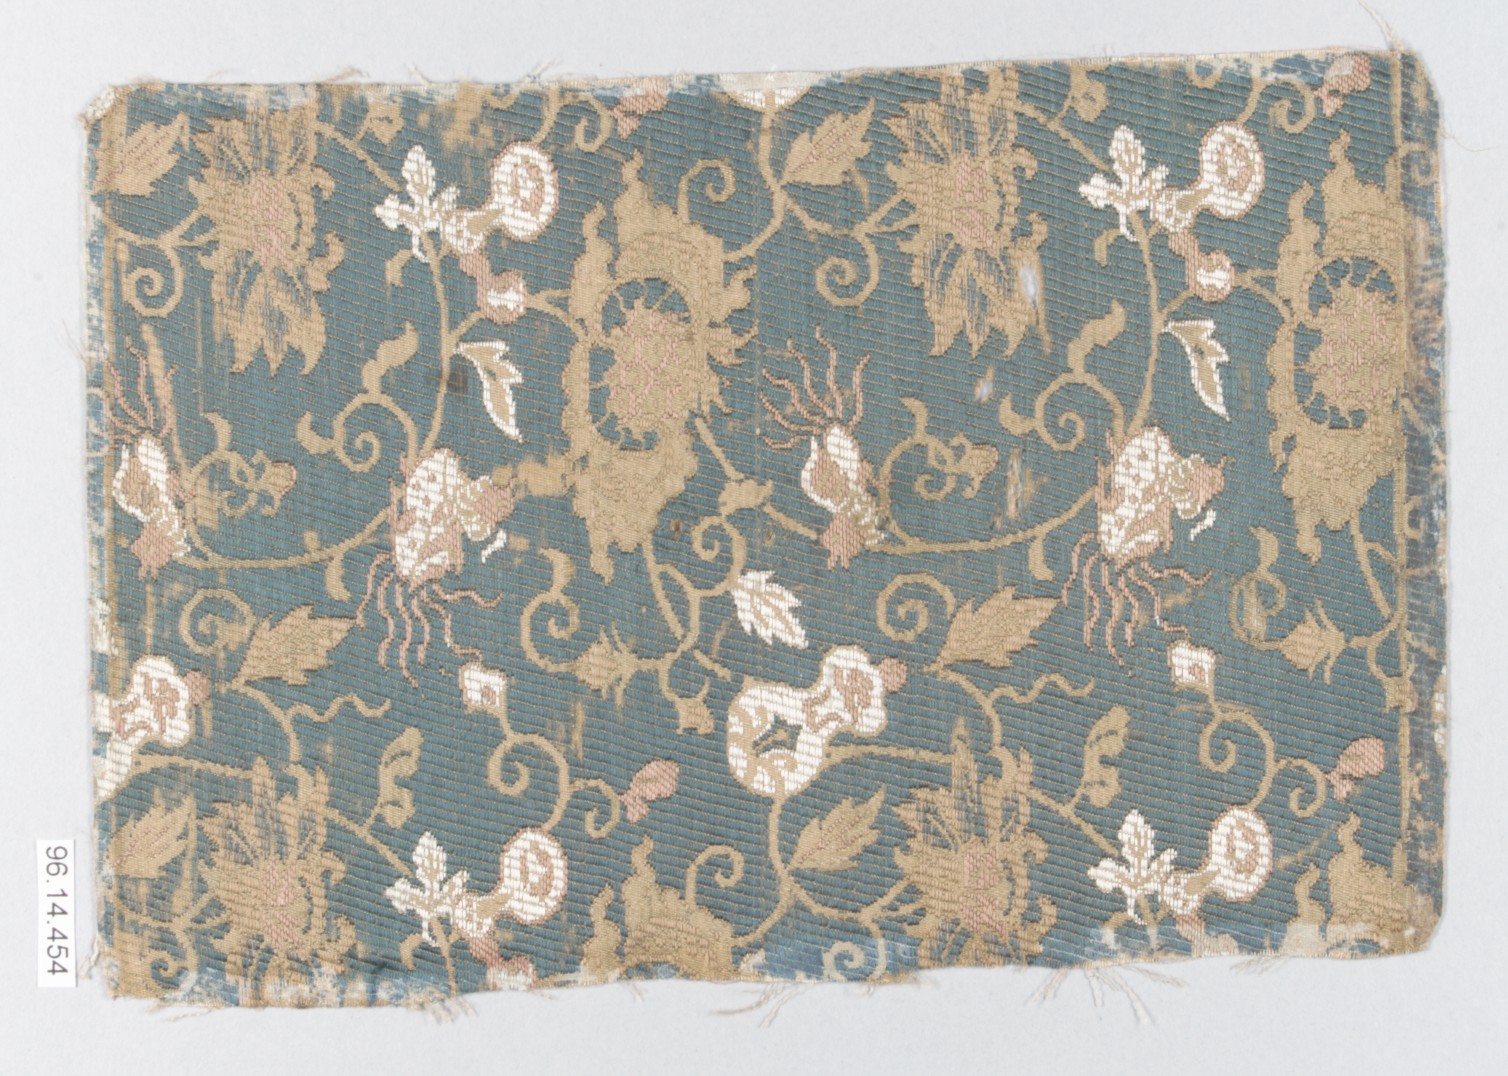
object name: piece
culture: japanese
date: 1701-1800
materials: silk